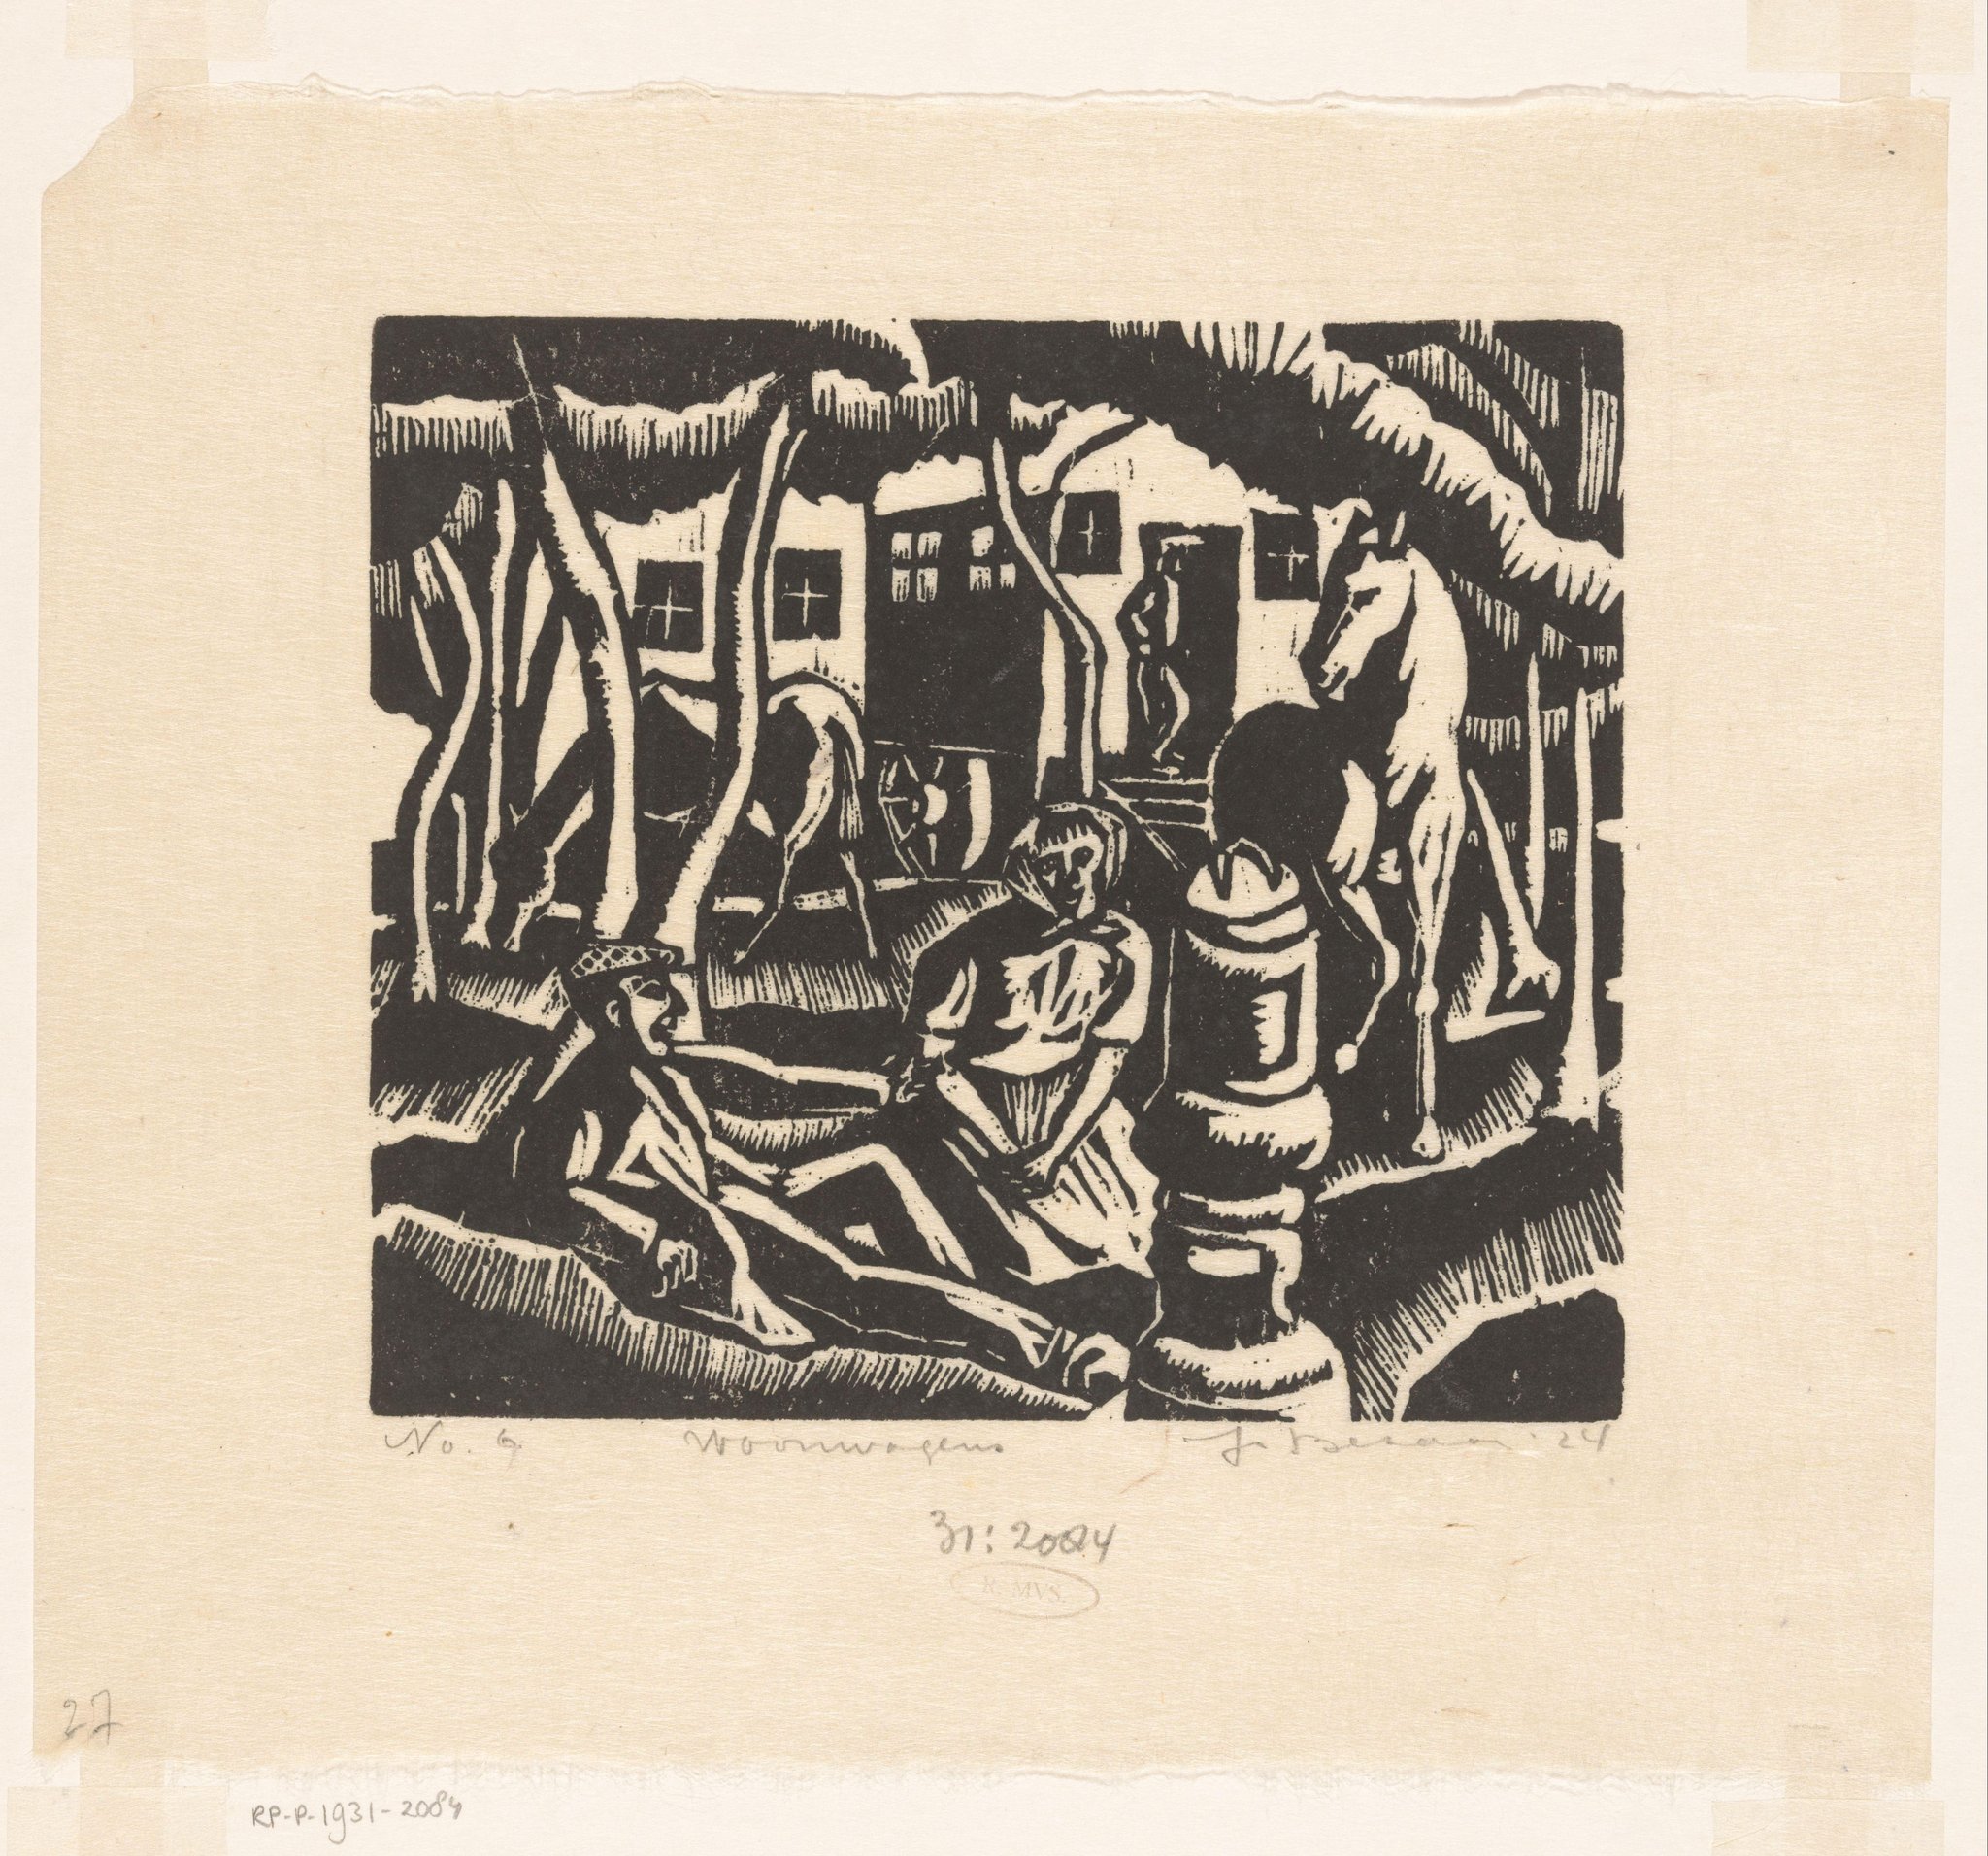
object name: print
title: Woonwagens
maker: jo bezaan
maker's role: draughtsman, print maker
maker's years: 1894-1952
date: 1924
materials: paper, ink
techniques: woodcut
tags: trailer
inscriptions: collector's mark: Lugt 2228, title: ‘Woonwagens’, signature and date: ‘Jo Bezaan '24’, number: ‘No. 6’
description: Man en vrouw, liggend en zittend op de grond, tussen twee paarden, met op de achtergrond een figuur in een deuropening van een woonwagen.